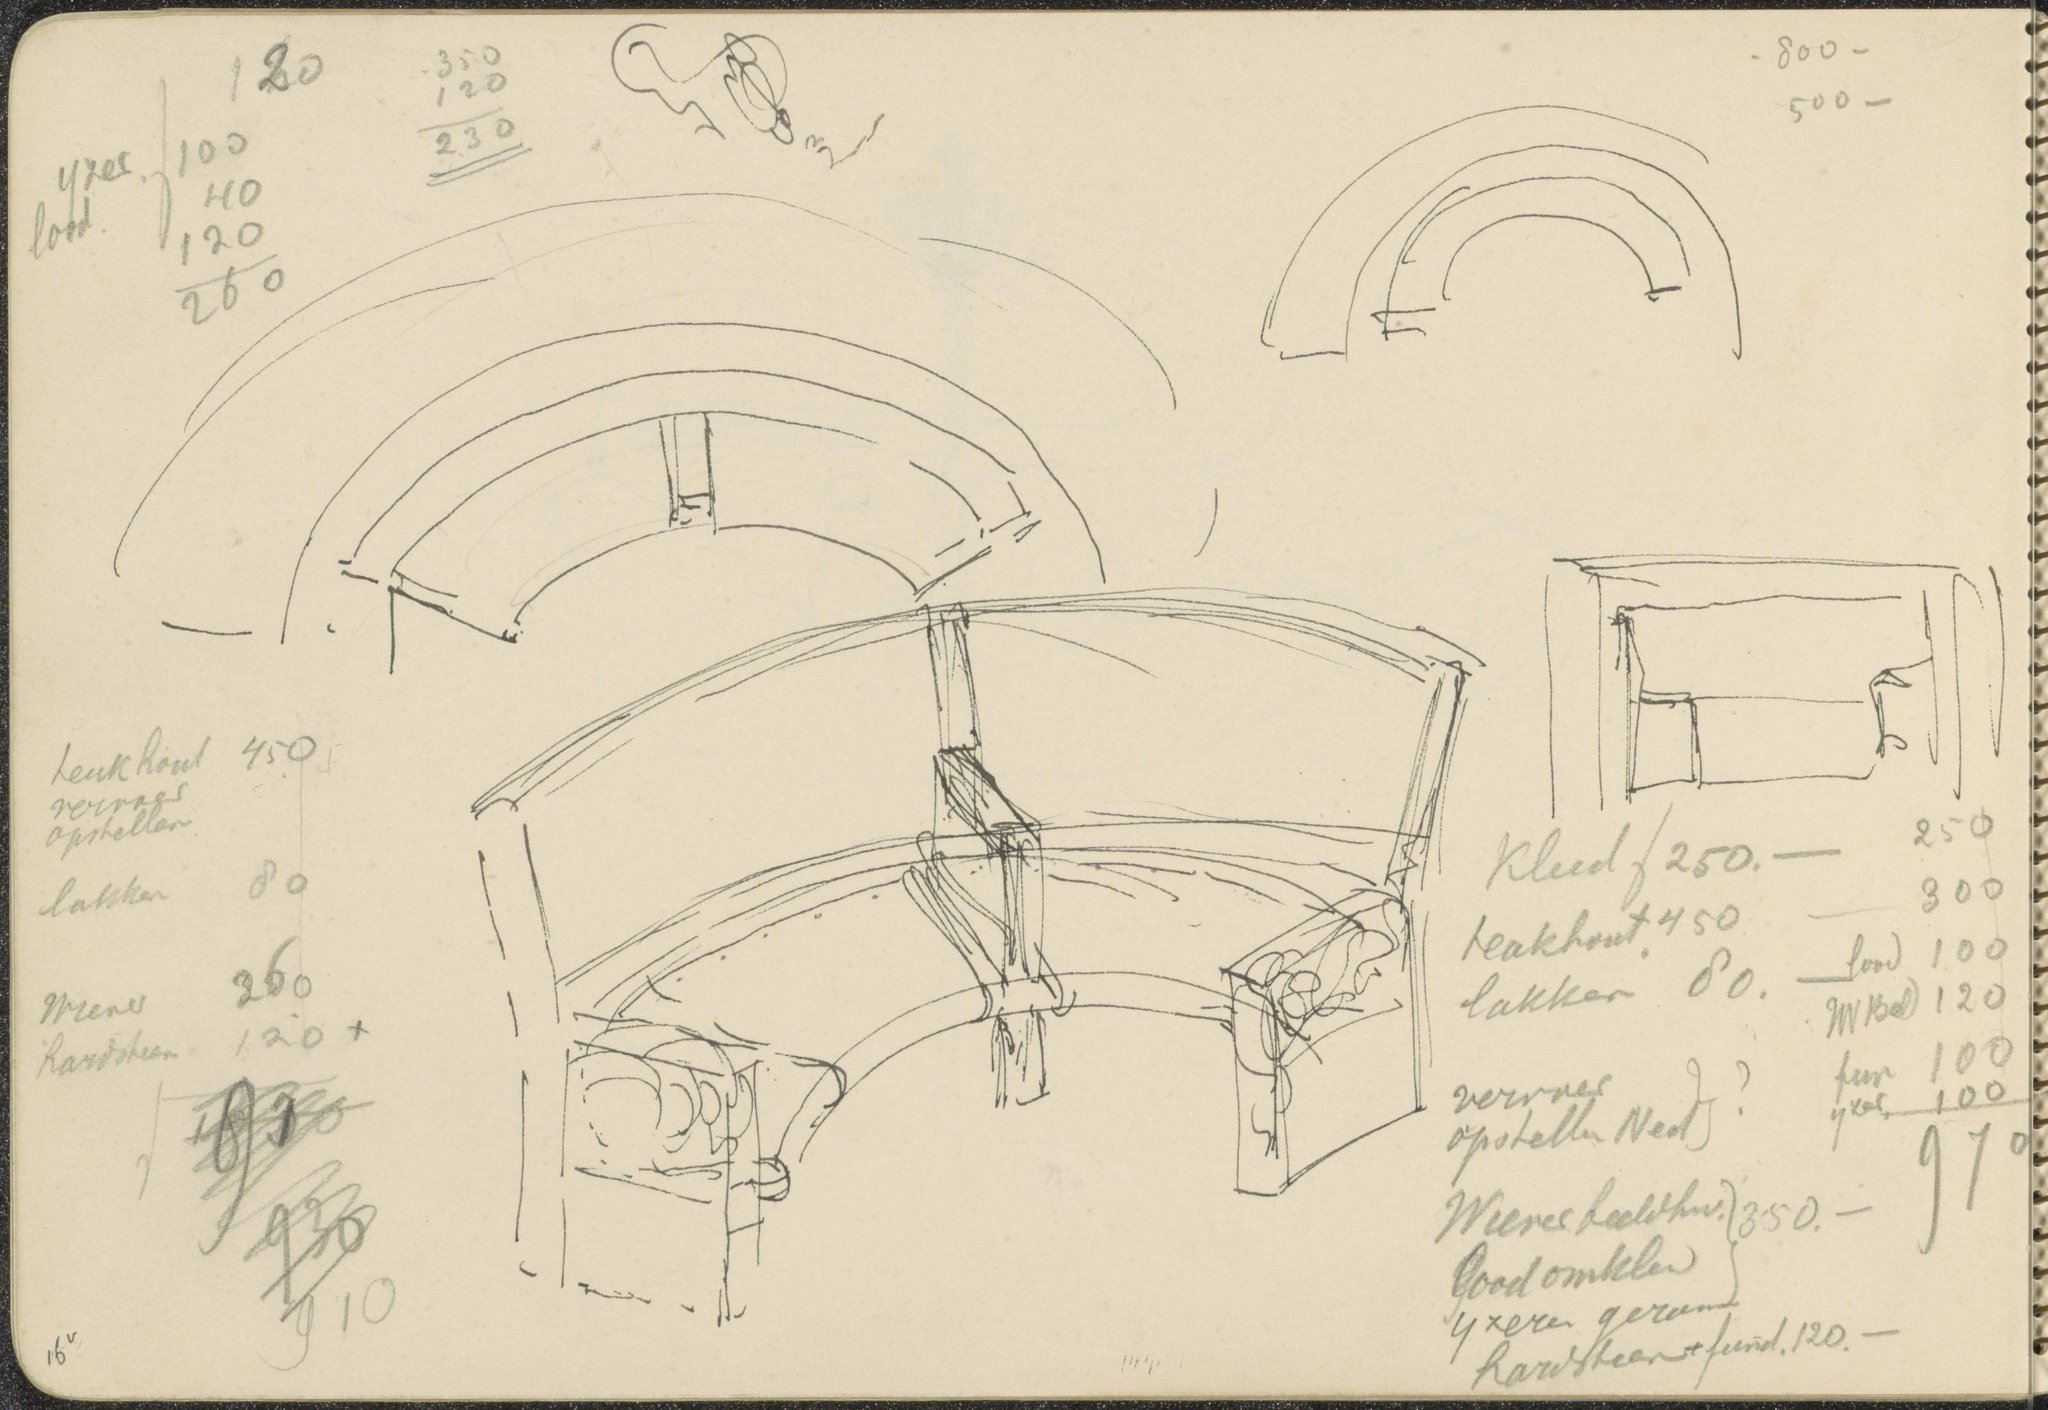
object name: sketchbook leaf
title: Ontwerpen voor een bank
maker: carel adolph lion cachet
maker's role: draughtsman, print maker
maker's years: 1864-1945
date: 1934-1943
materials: ink, paper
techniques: pen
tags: bench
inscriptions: annotation: ‘[....]’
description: Blad 16 verso uit een schetsboek met 19 bladen.